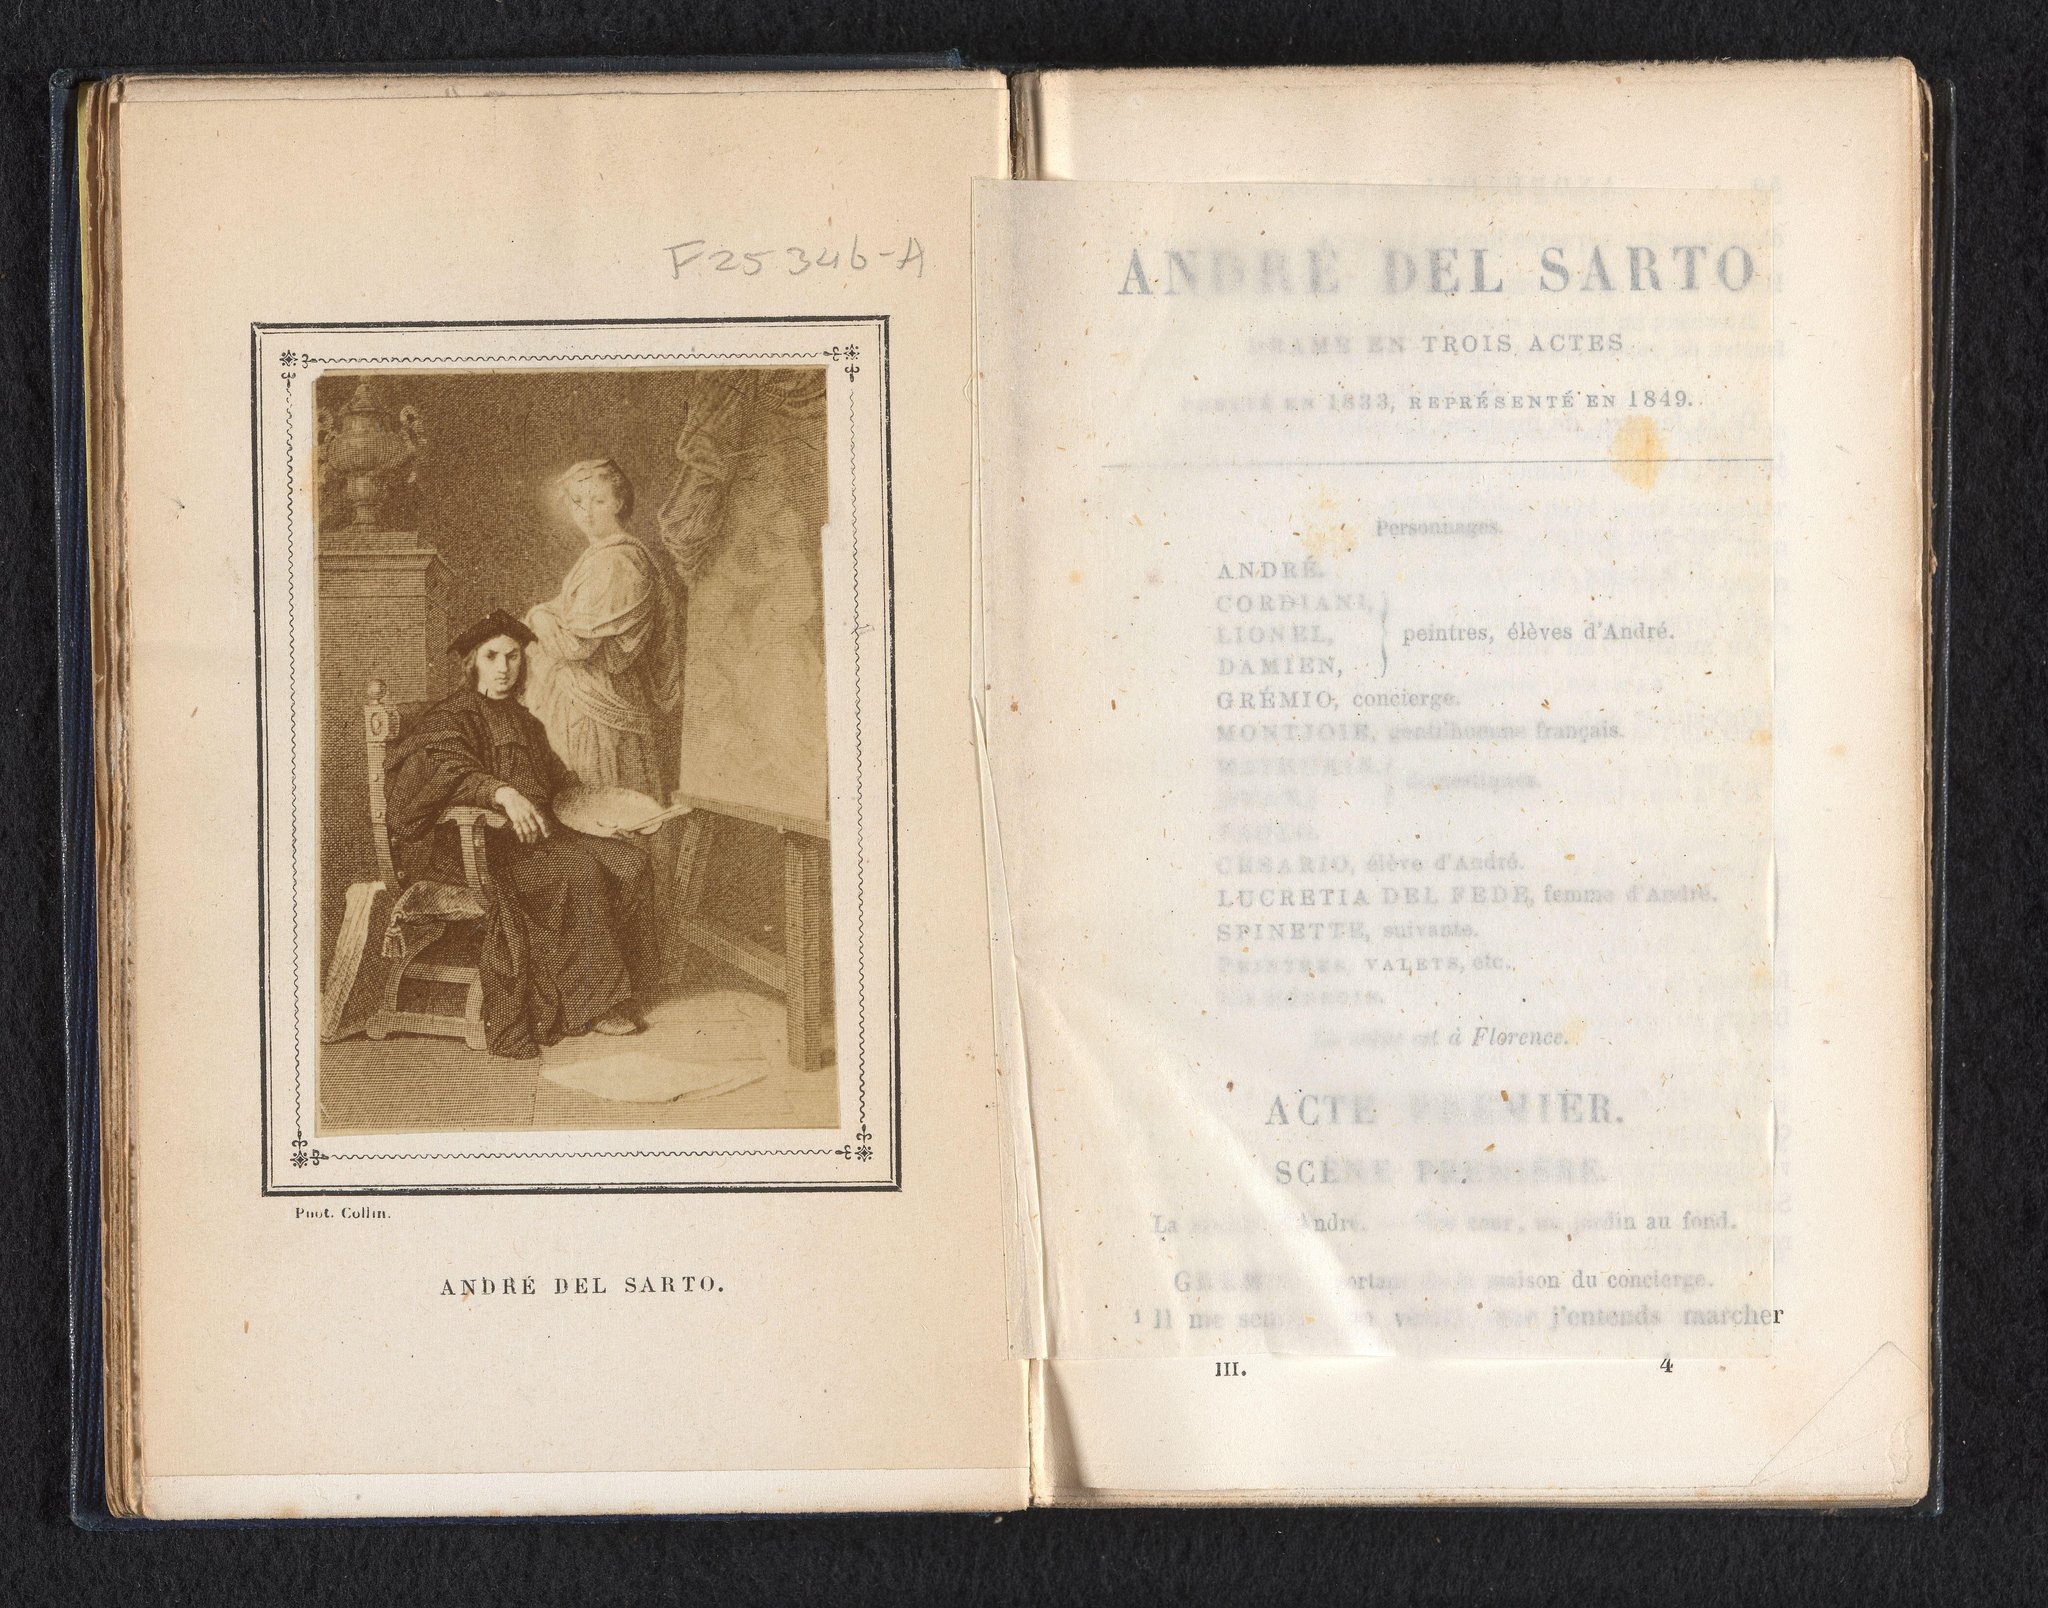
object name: photograph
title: André del Sarto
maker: collin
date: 1852-1867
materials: paper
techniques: albumen print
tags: print, e.g.: engraving, etching, lithograph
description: Foto op tweede ongenummerde pagina na pagina 48.